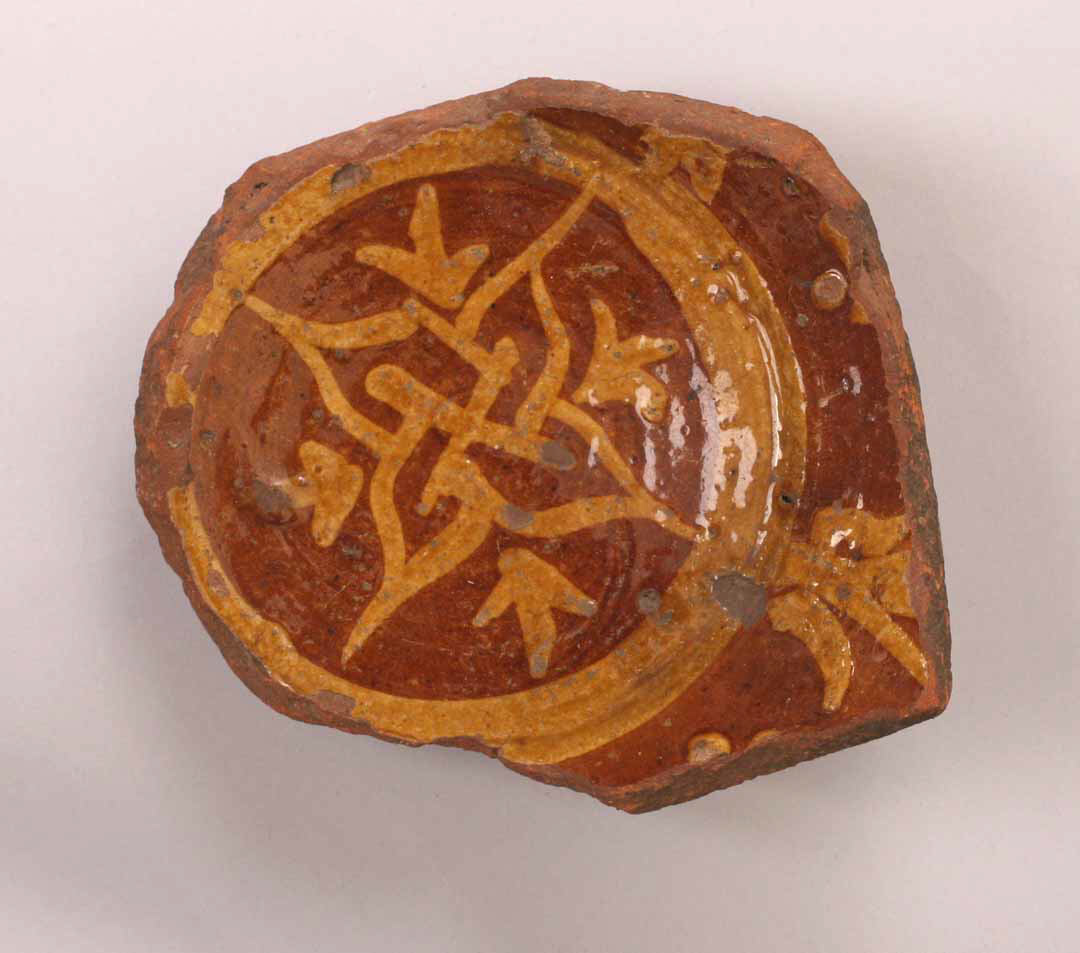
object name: fragment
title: Ceramic Fragment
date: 1301-1500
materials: earthenware, glaze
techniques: painting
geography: egypt